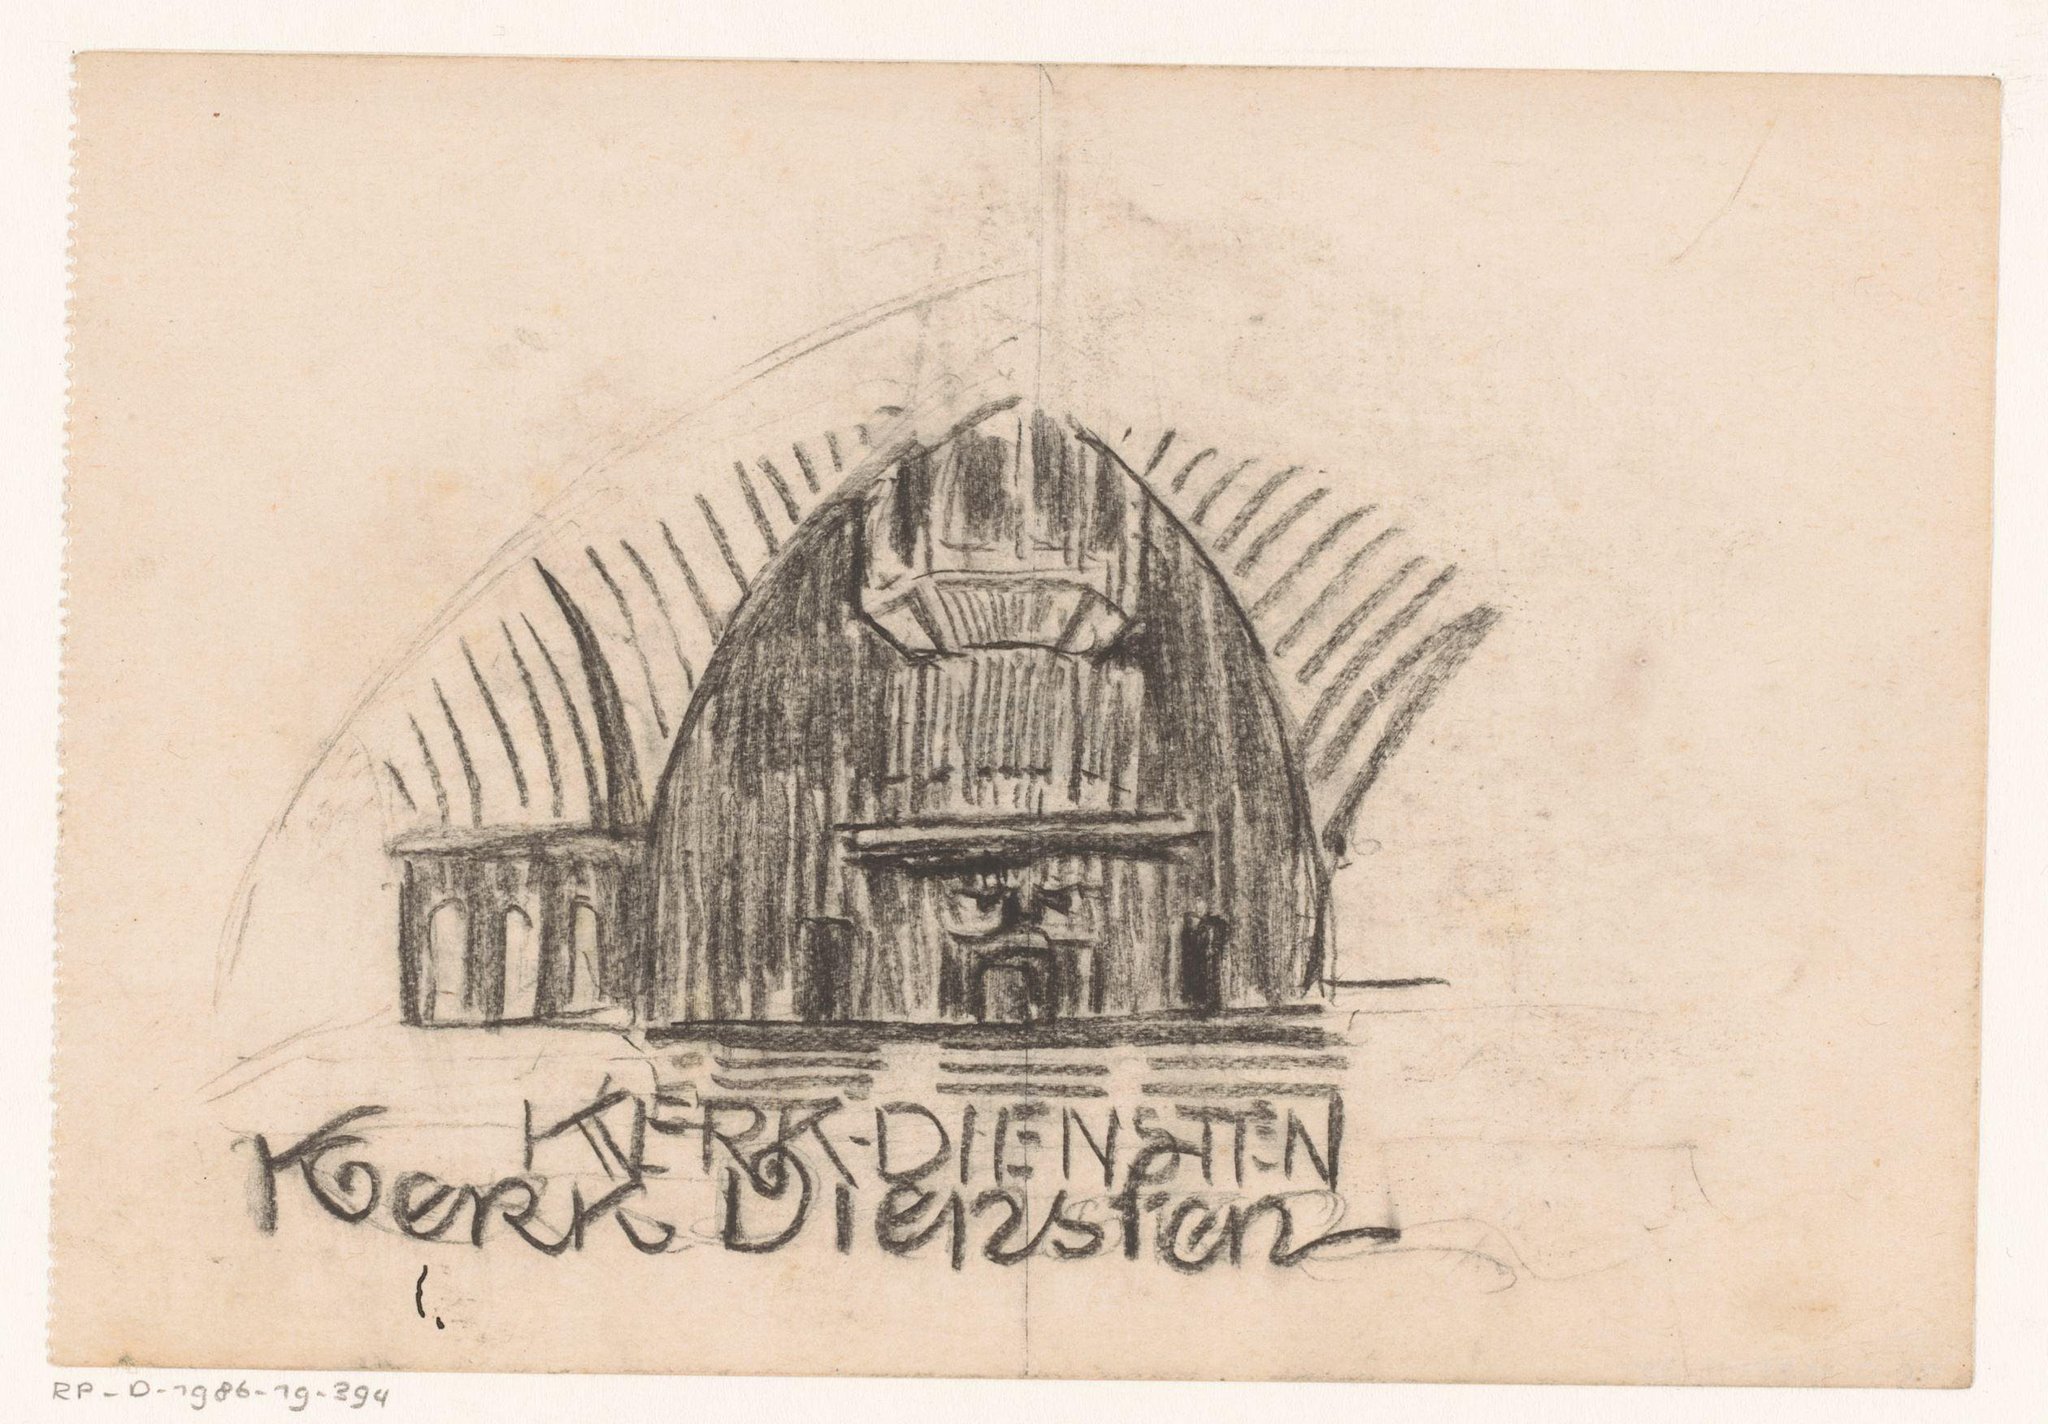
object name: design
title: Kerkinterieur met predikant achter de kansel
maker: reinier willem petrus de vries (1874-1953)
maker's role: draughtsman, print maker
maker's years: 1874-1953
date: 1884-1952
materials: chalk, paper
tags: pulpit, ambo, chancel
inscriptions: collector's mark: ‘R:MVS.’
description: Vermoedelijk een ontwerp voor de Hilversumse afdeling van de Nederlandse Protestantenbond.